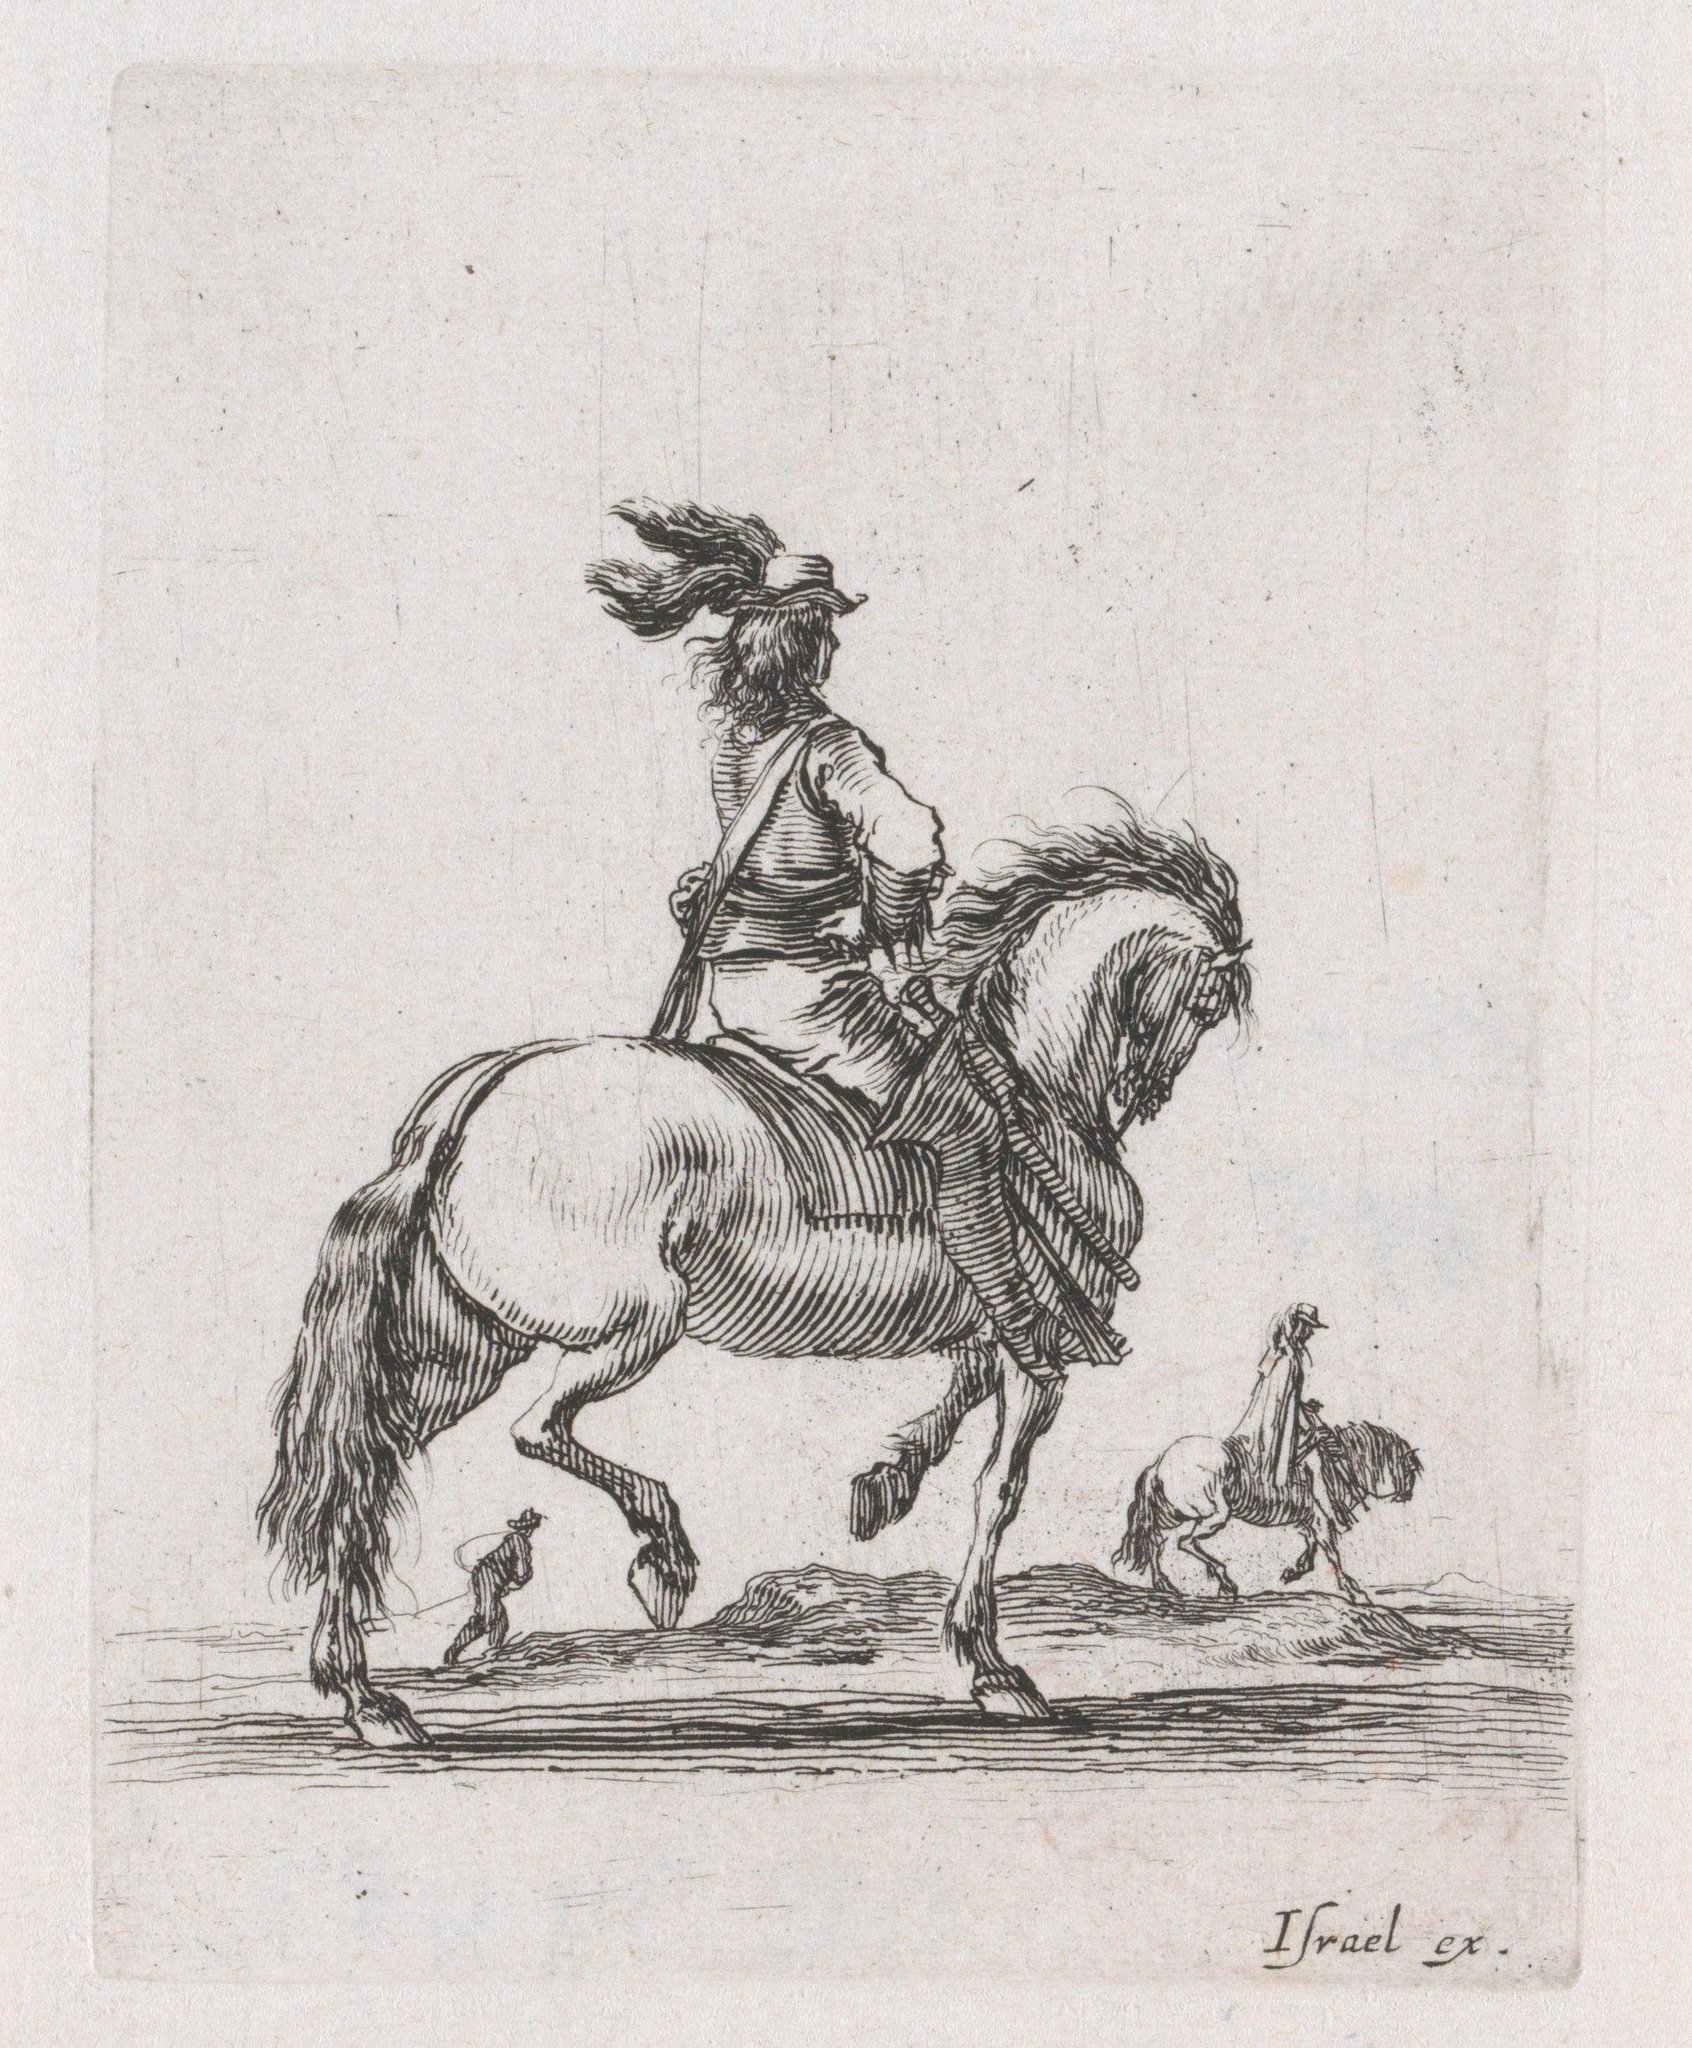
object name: print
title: Diverse oefeningen van de cavalerie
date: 1620-1664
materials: paper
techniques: etching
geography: paris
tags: riding a horse, ass, or mule; rider, horseman, horse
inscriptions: collector's mark: Lugt 240